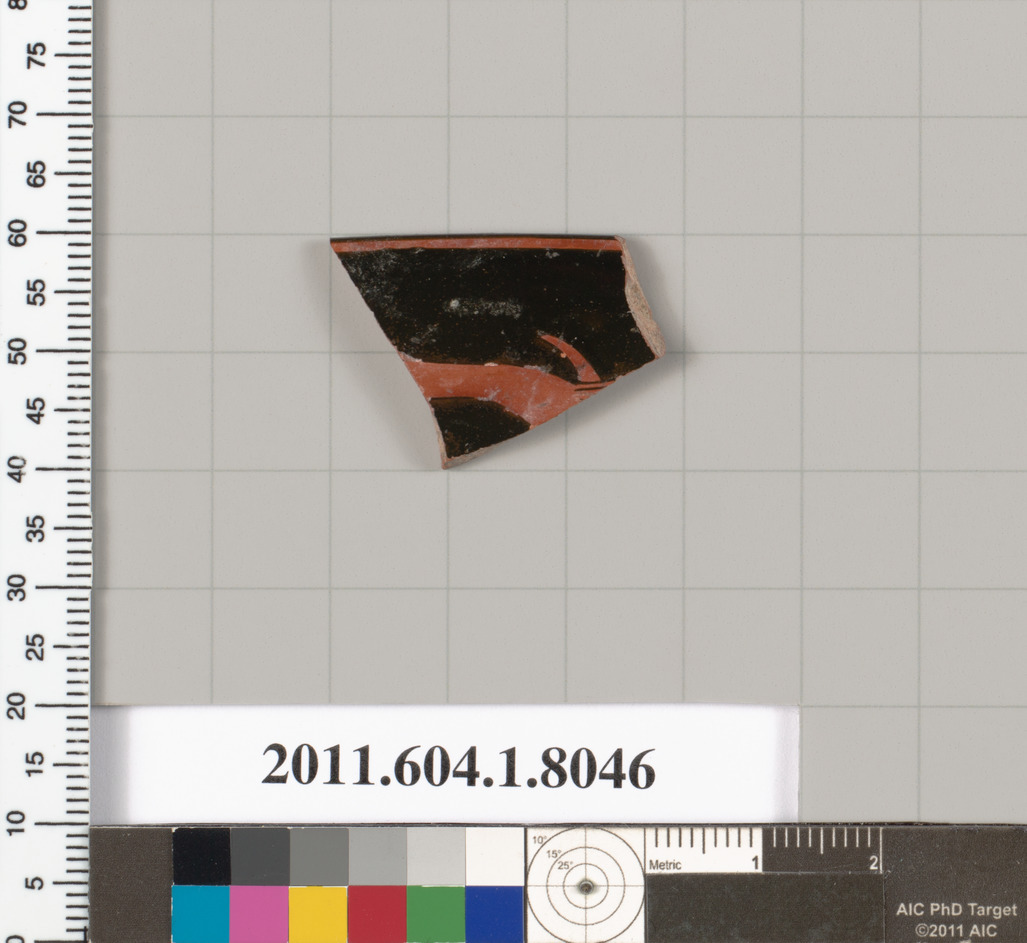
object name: kylix fragment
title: Terracotta rim fragment of a kylix (drinking cup)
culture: greek, attic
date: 510-490 BCE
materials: terracotta